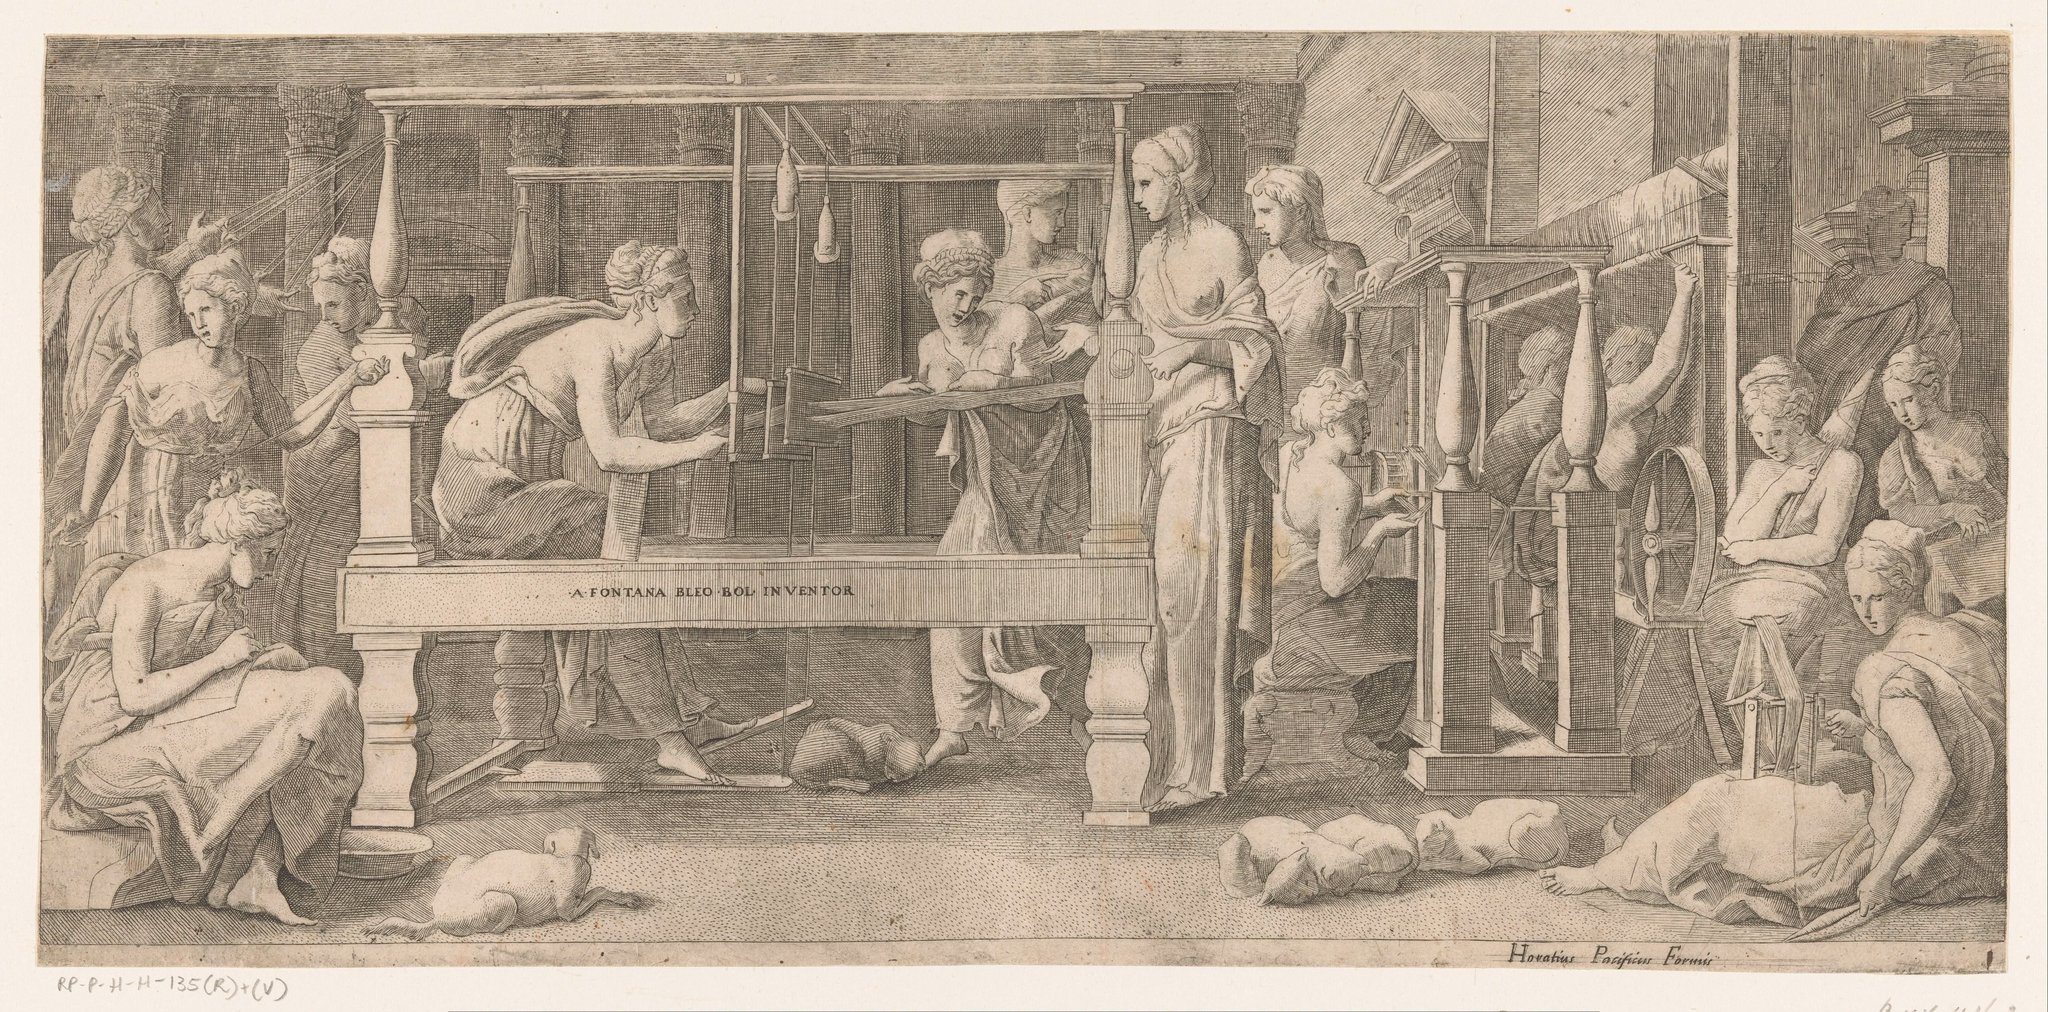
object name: print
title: Penelope en haar vrouwen aan het weven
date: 1529-1542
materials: paper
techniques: engraving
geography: italy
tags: penelope weaving laertes' shroud (homer, odyssey ii 94-100; xix 138-155)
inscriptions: number: ‘1’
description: Gezicht in een werkplaats waar Penelope en andere vrouwen met behulp van weefgetouwen aan het weven zijn.